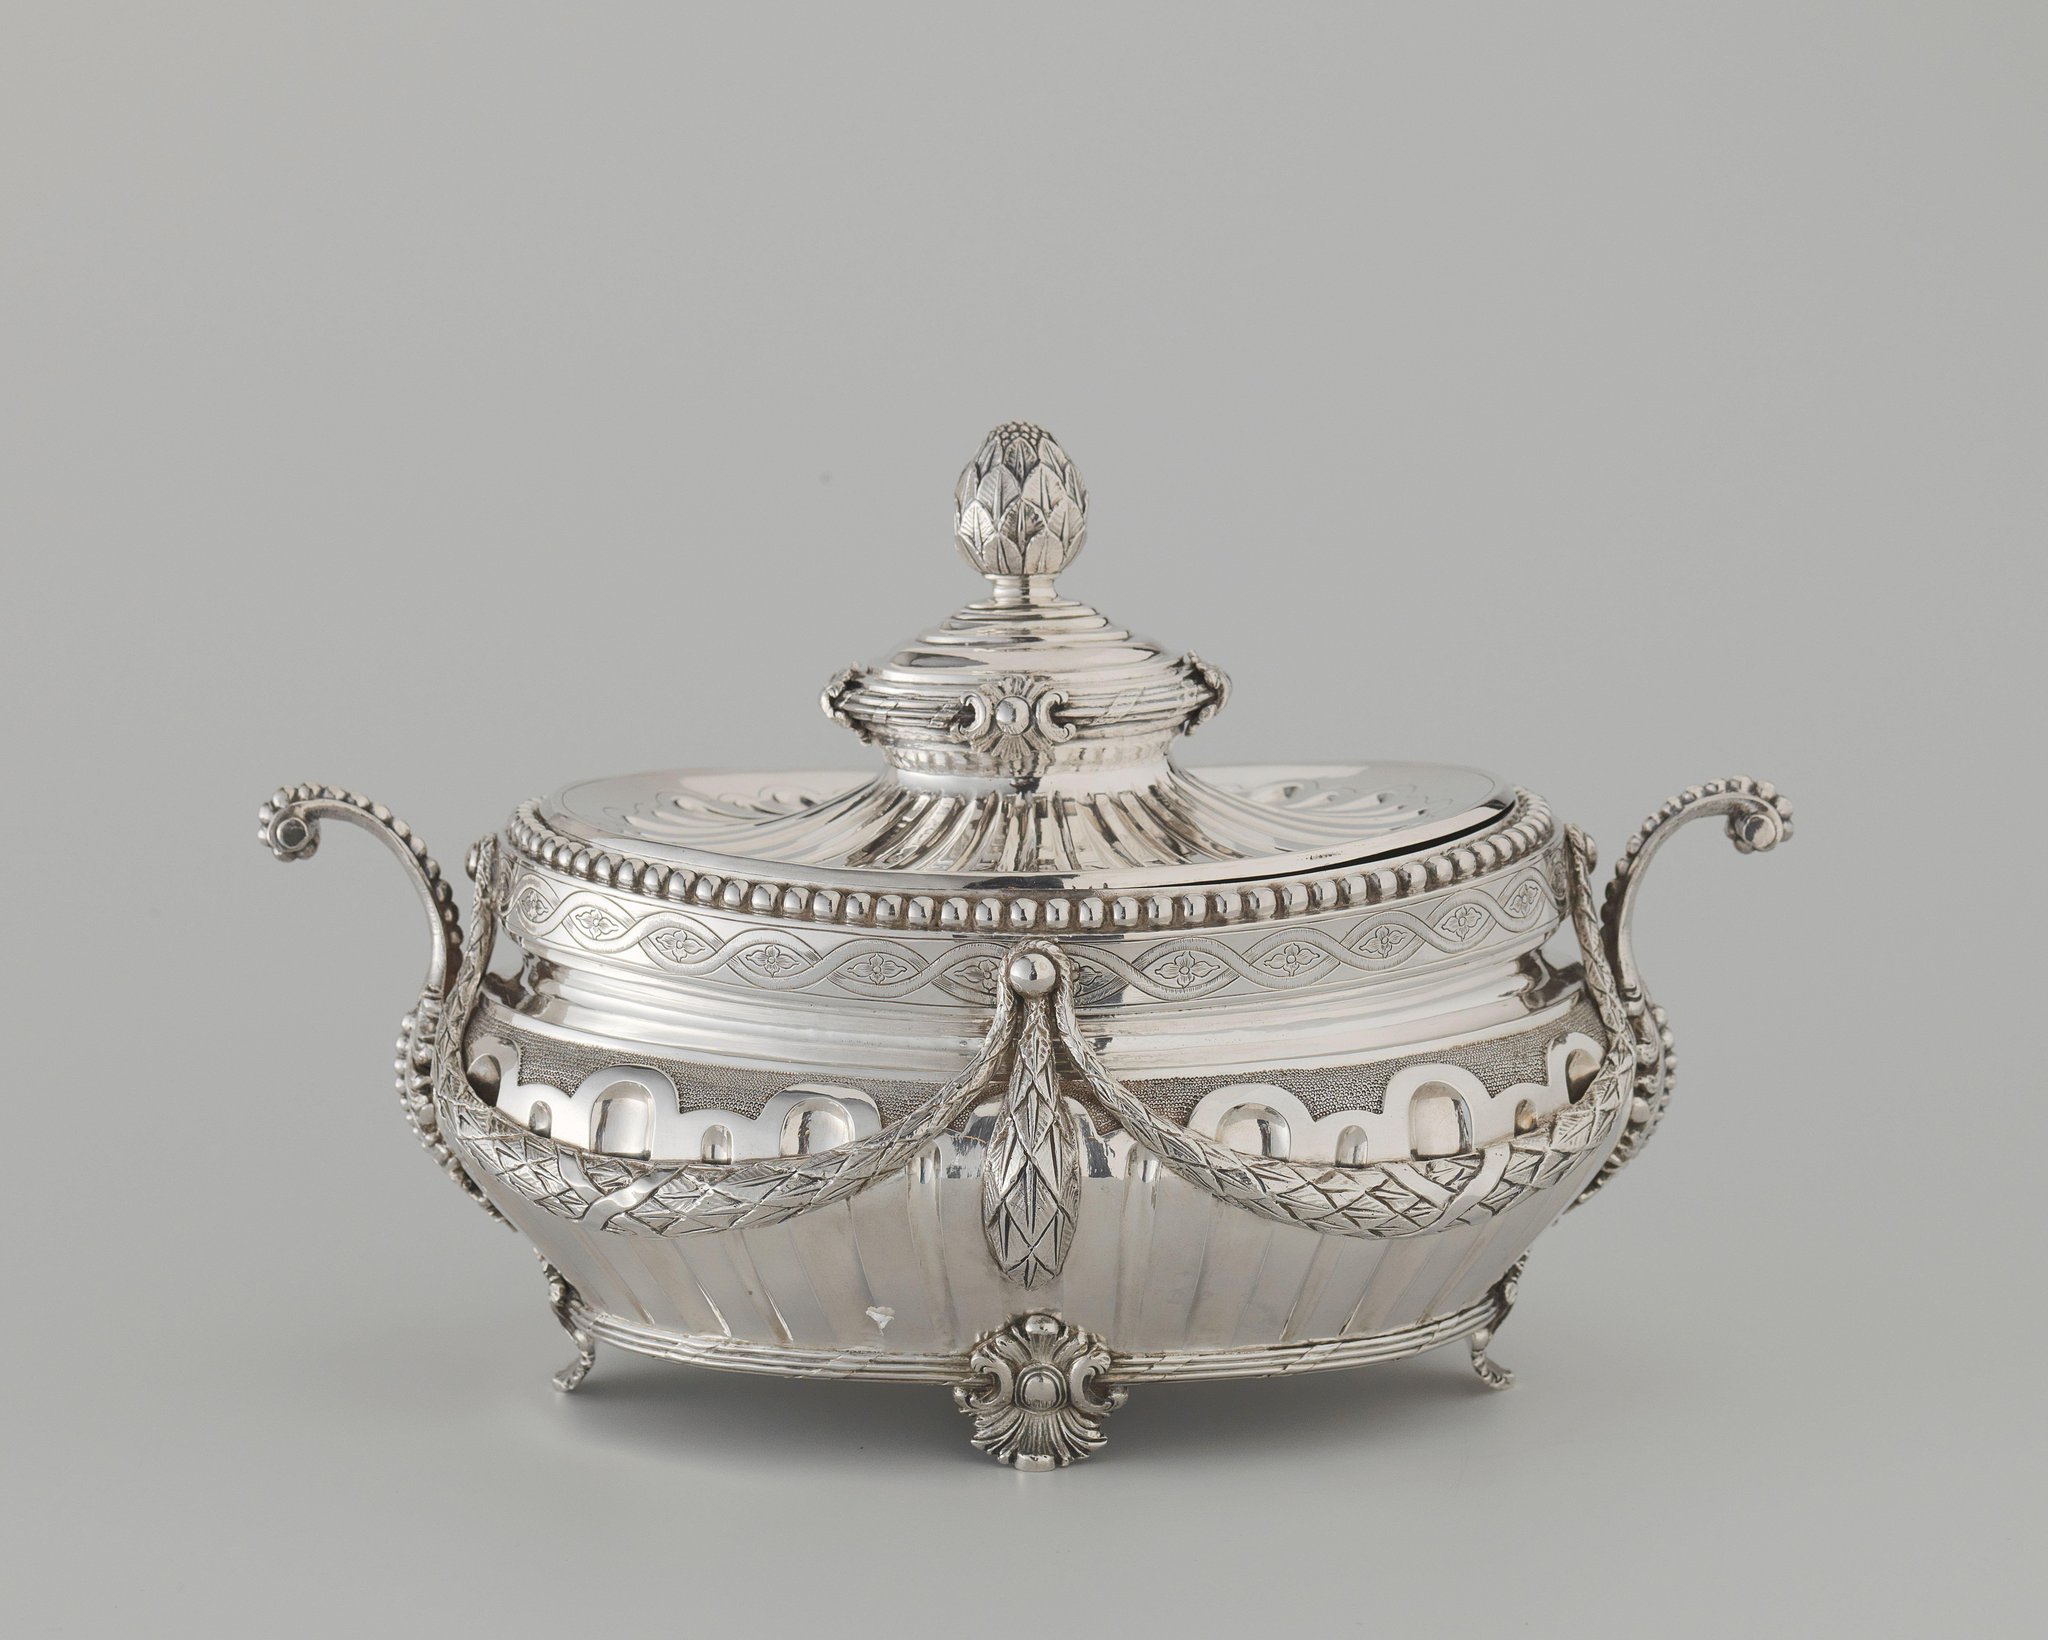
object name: tureen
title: Een grote (A) en twee kleine (B en C) ovale terrines in Lodewijk XVI-stijl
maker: philippus priee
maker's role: silversmith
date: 1773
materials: silver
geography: middelburg